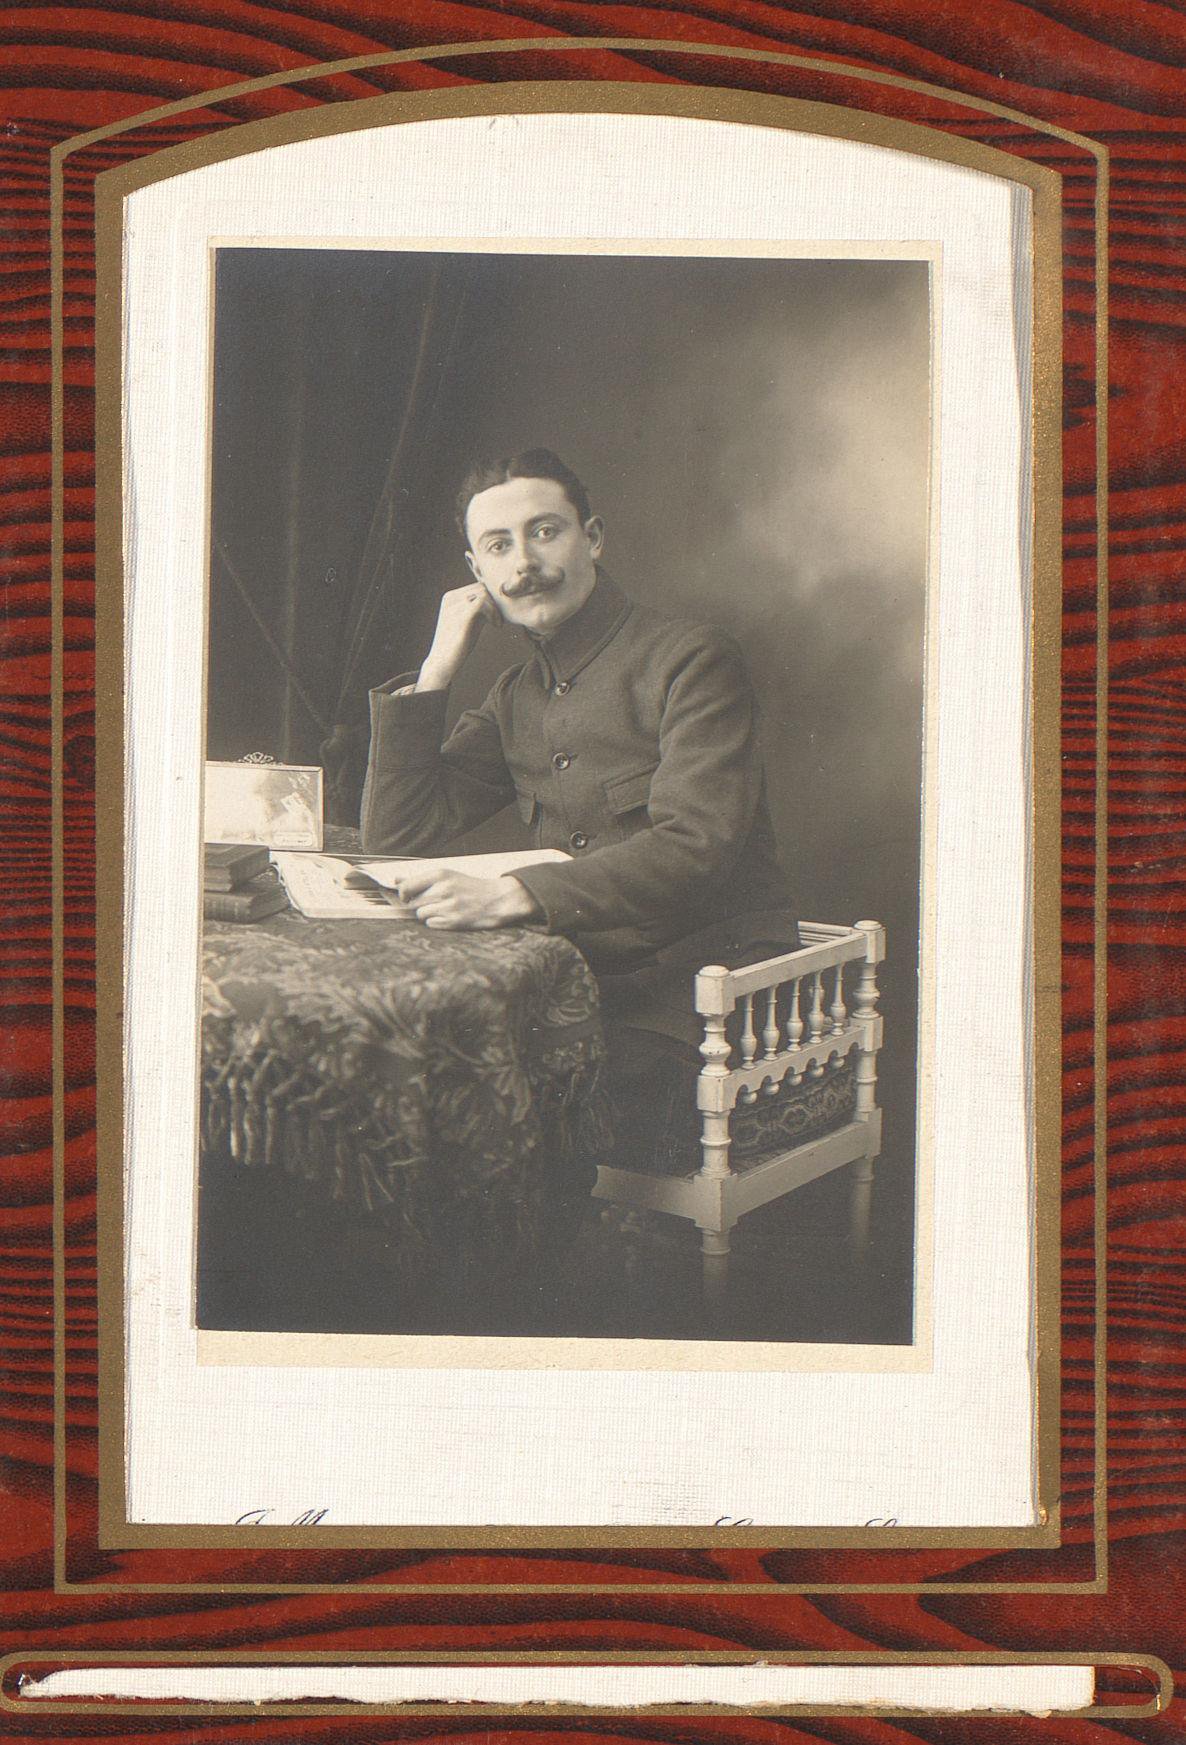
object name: photograph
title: Portret van een man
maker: Anonymous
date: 1880-1930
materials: cardboard, photographic support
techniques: gelatin silver print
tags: adult man, historical persons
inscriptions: inscription: ‘F. Muzart, 25 Place de Beaune, [...]’